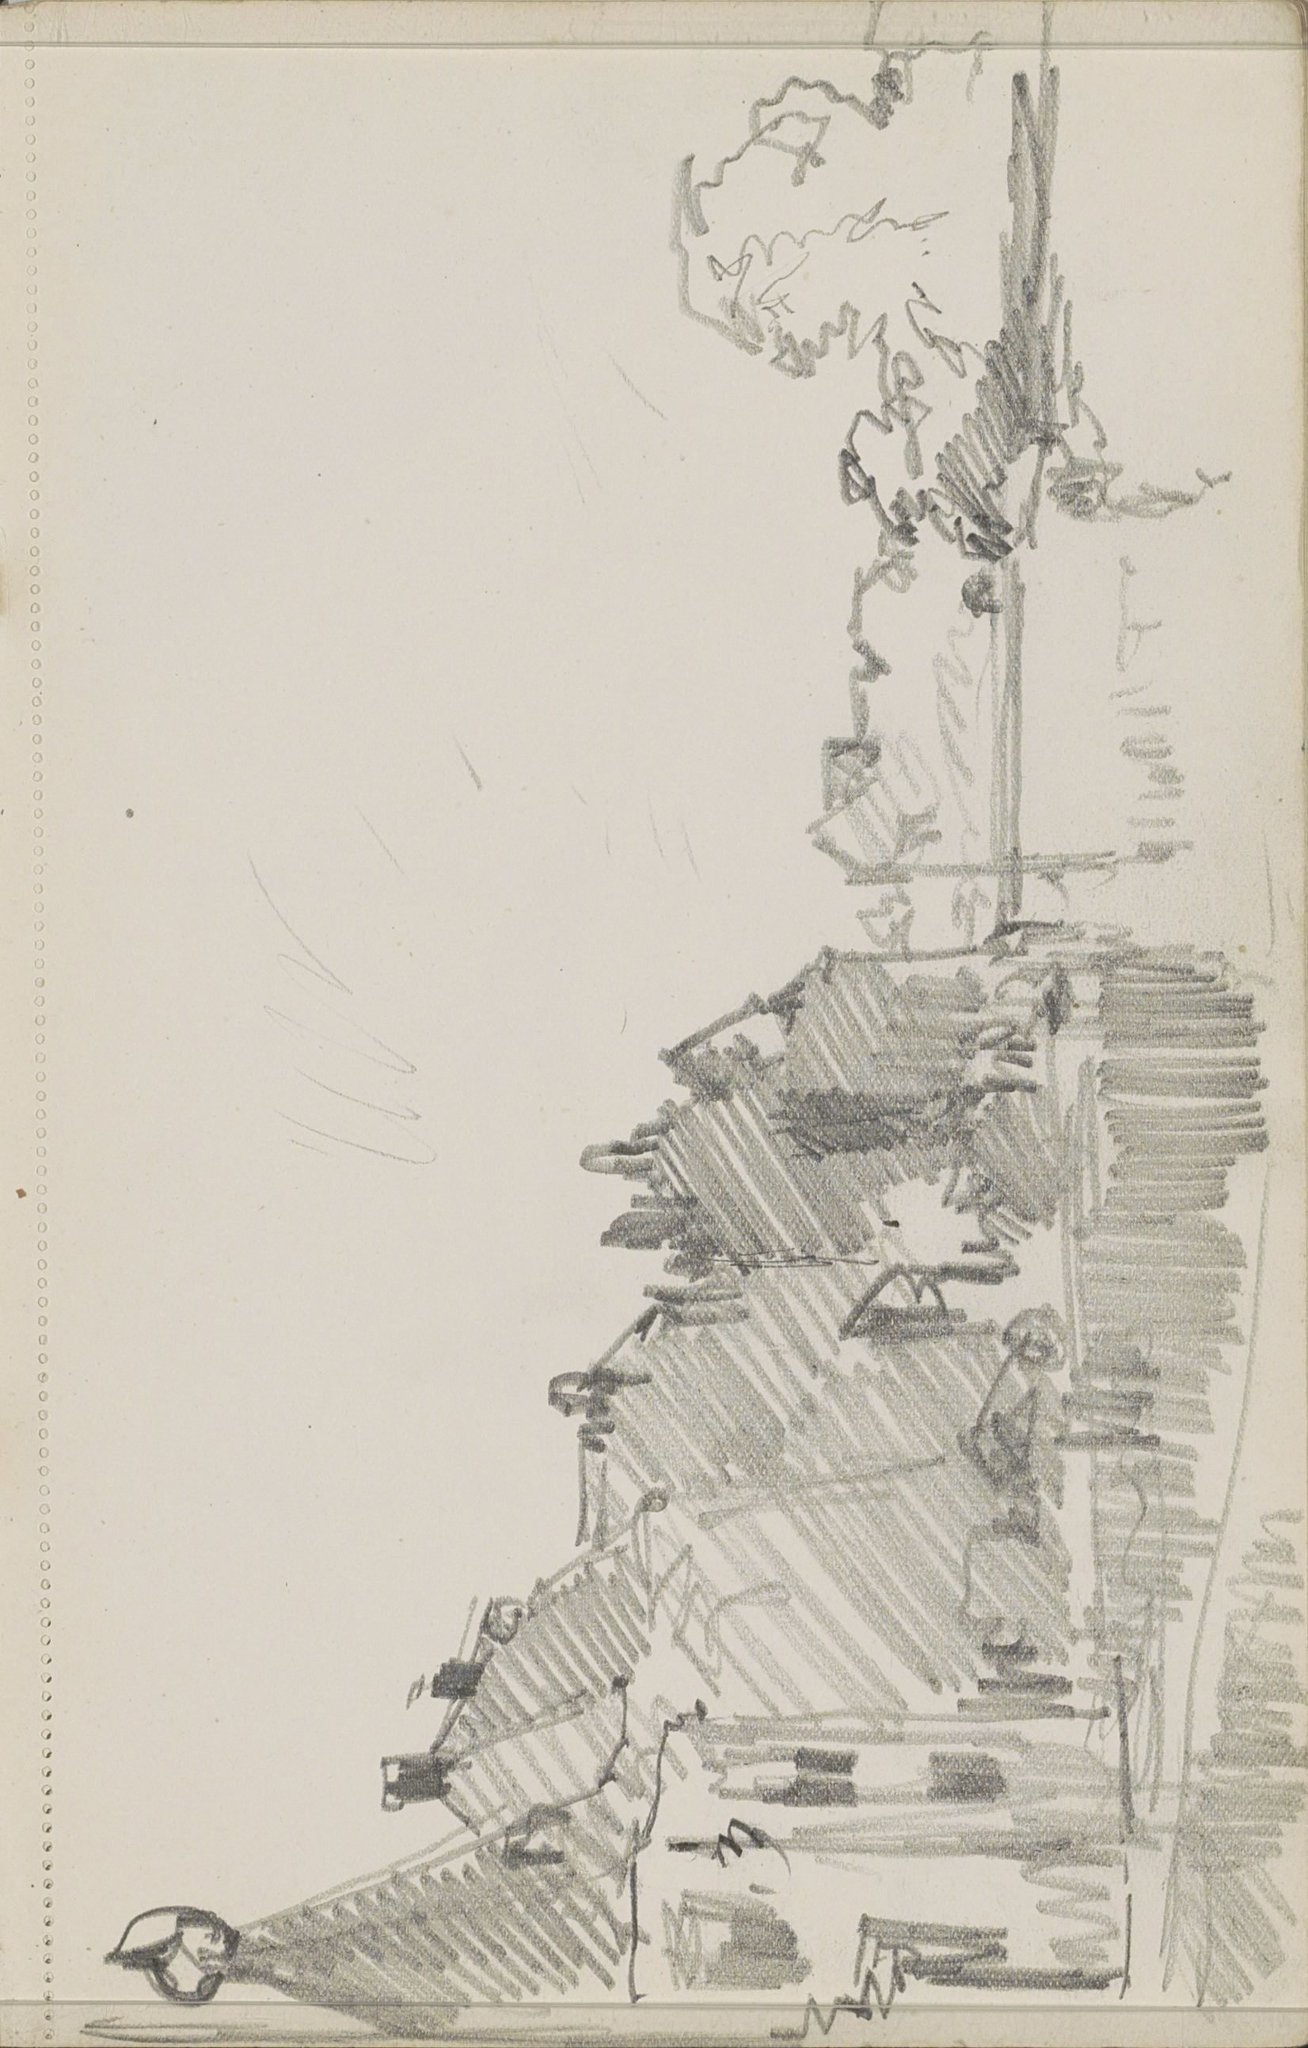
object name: sketchbook leaf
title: Rij huizen aan het water in een stad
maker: cornelis vreedenburgh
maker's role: draughtsman, print maker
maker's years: 1880-1946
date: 1890-1946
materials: paper, pencil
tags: city-view, and landscape with man-made constructions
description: Blad 5 recto uit een schetsboek met 61 bladen.